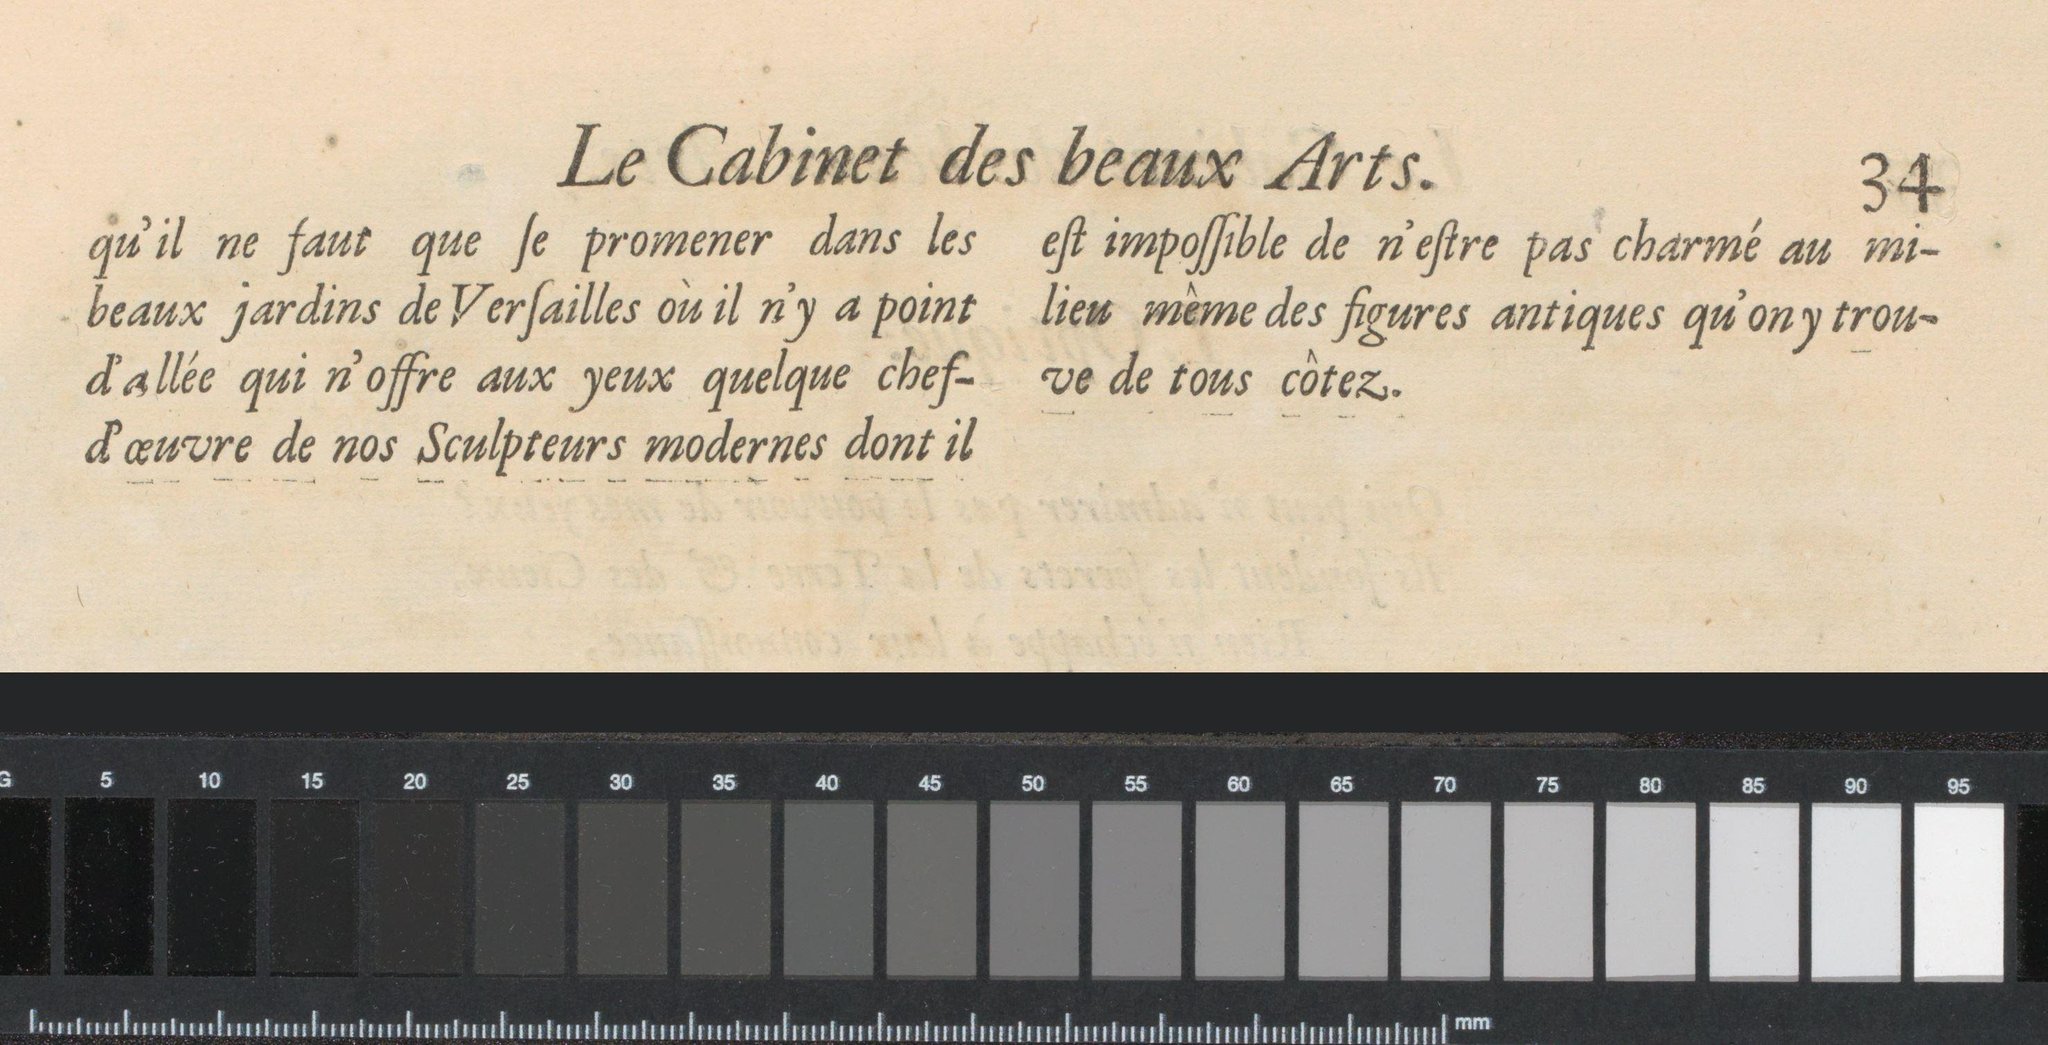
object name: album leaf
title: Tekstblad met verklaring van de prent over Beeldhouwkunst, p. 34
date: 1695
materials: paper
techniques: letterpress printing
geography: paris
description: Verklaring van de prent met voorstelling van Beeldhouwkunst in het Frans. Pagina 34. Tekstblad maakt deel uit van een album.